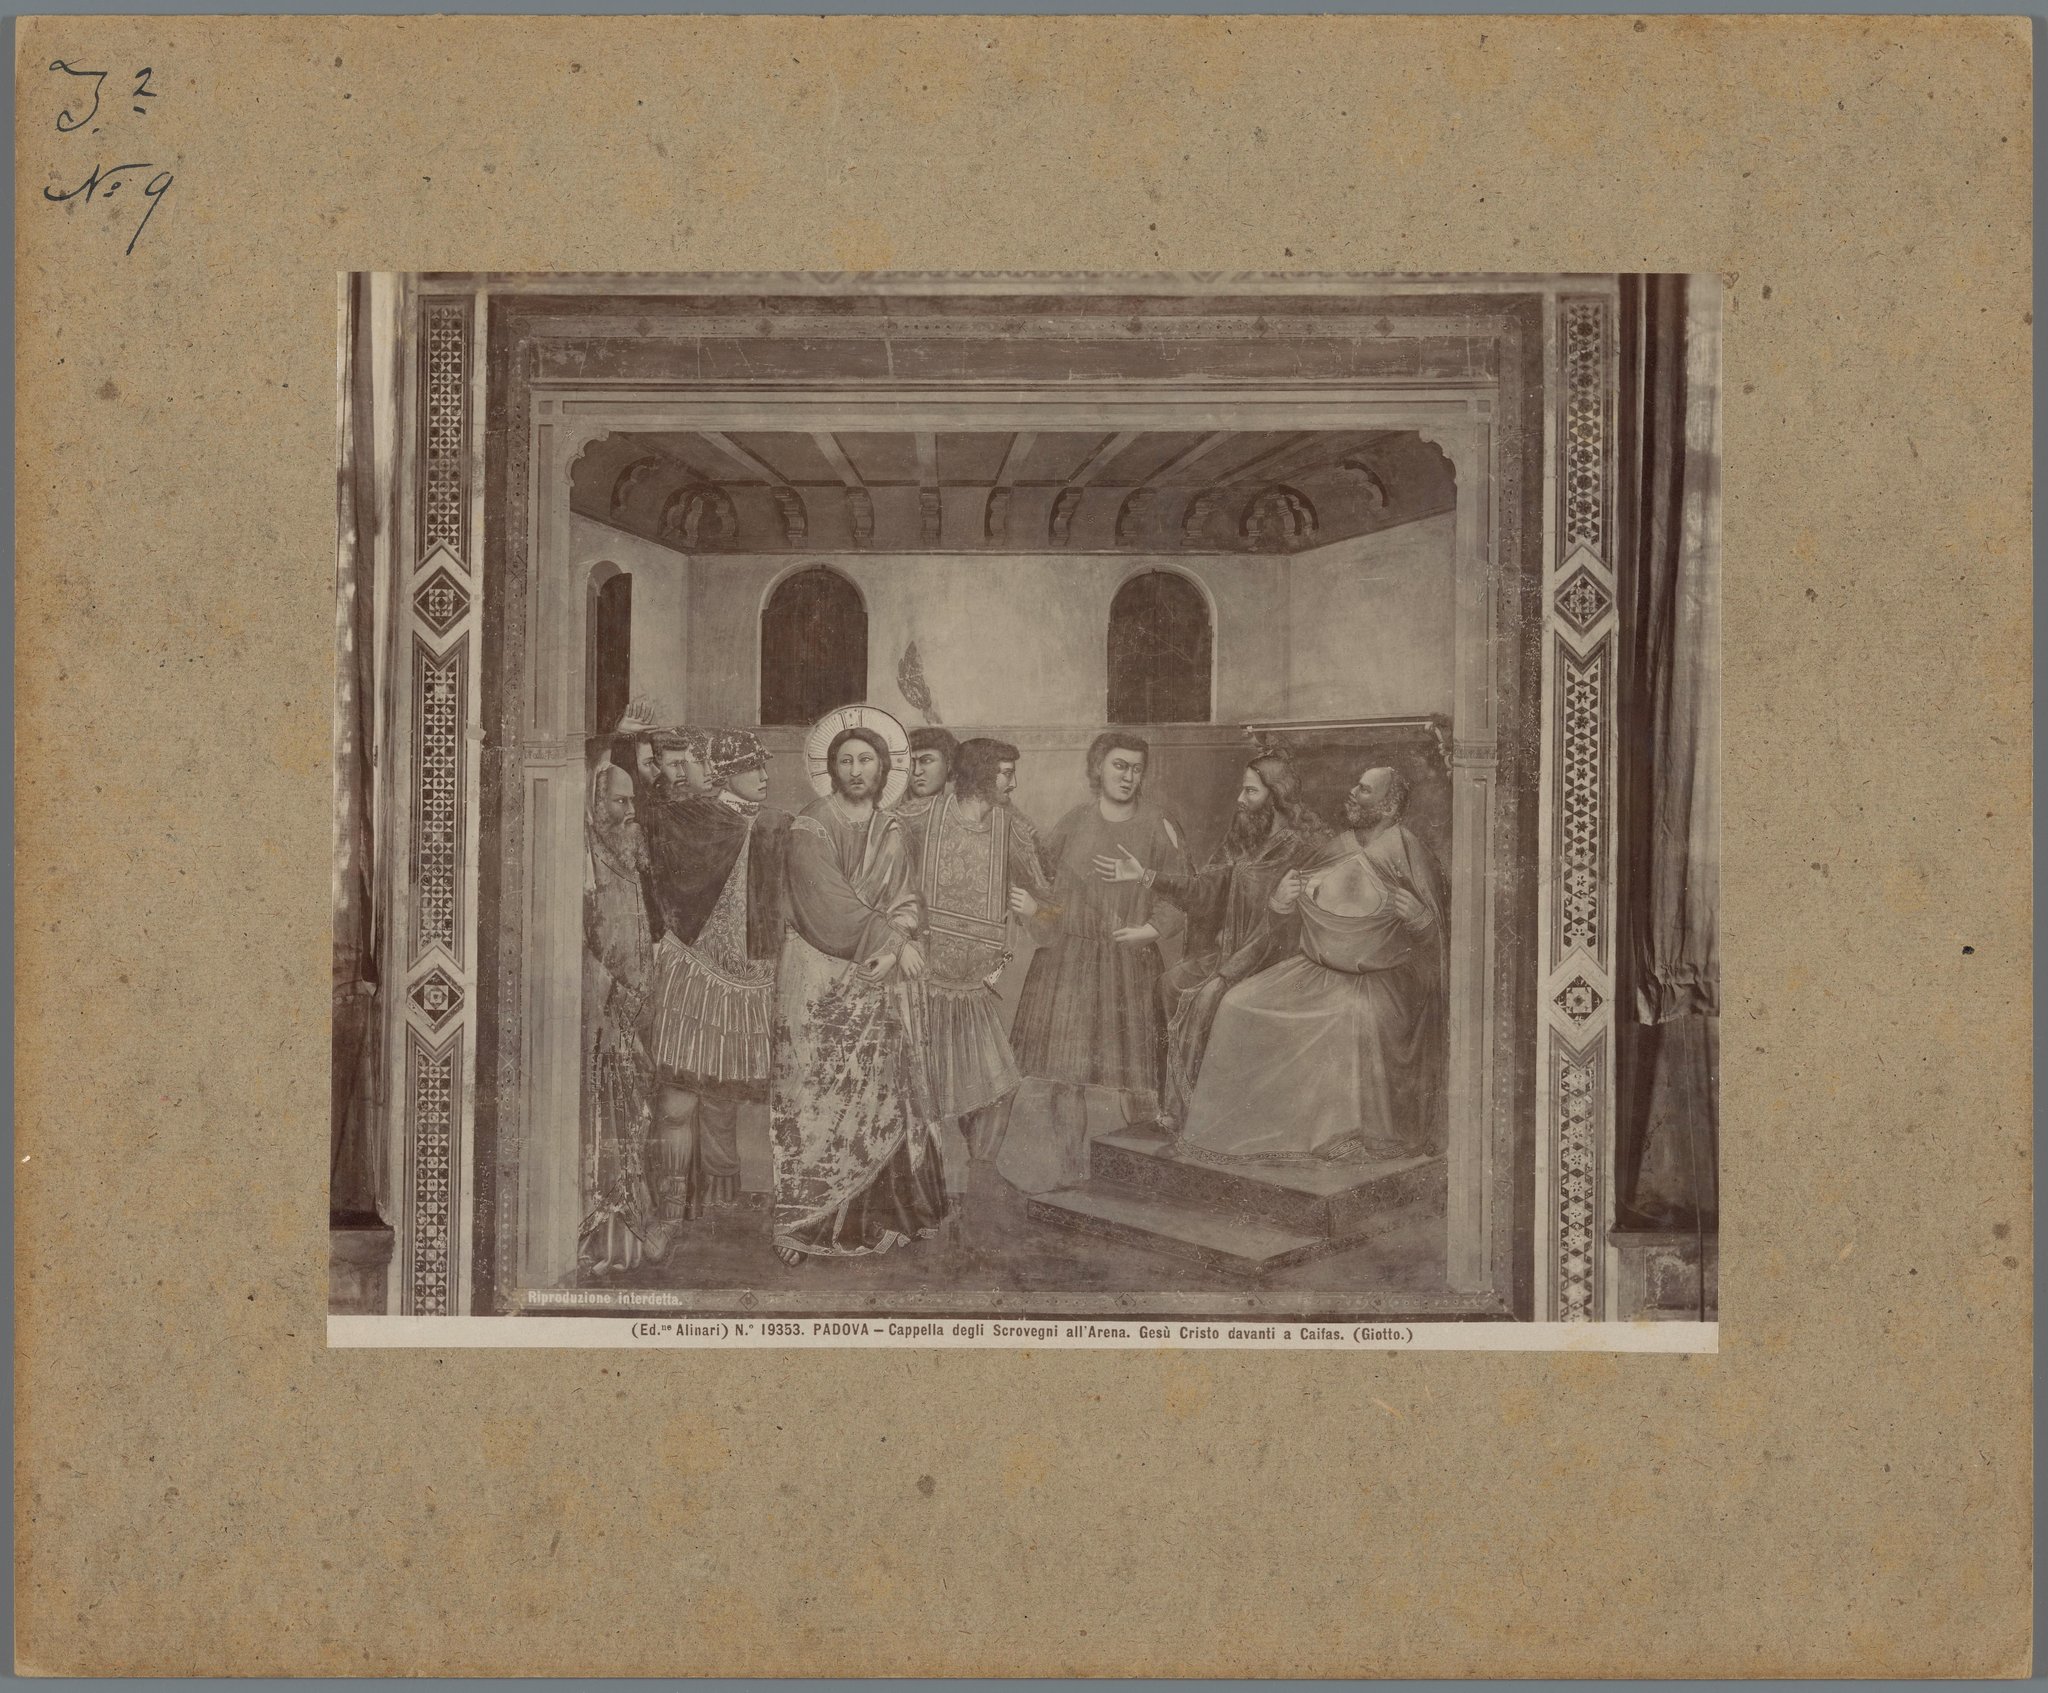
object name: photograph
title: PADOVA - Cappella degli Scrovegni all'Arena. Gesù Cristo davanti a Caifas.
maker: giotto de bondone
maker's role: painter, sculptor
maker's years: 1266-1337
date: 1875-1900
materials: cardboard, photographic support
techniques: albumen print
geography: scrovegnikapel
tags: christ before the sanhedrin with caiaphas as high priest, and possibly annas; maybe a soldier about to strike christ because he keeps silent (matthew 26:57-66; mark 14:53-64; luke 22:54, 22:66-71)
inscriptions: collector's mark: Lugt 3937, number: ‘P.e 2.a N.o 19353.’